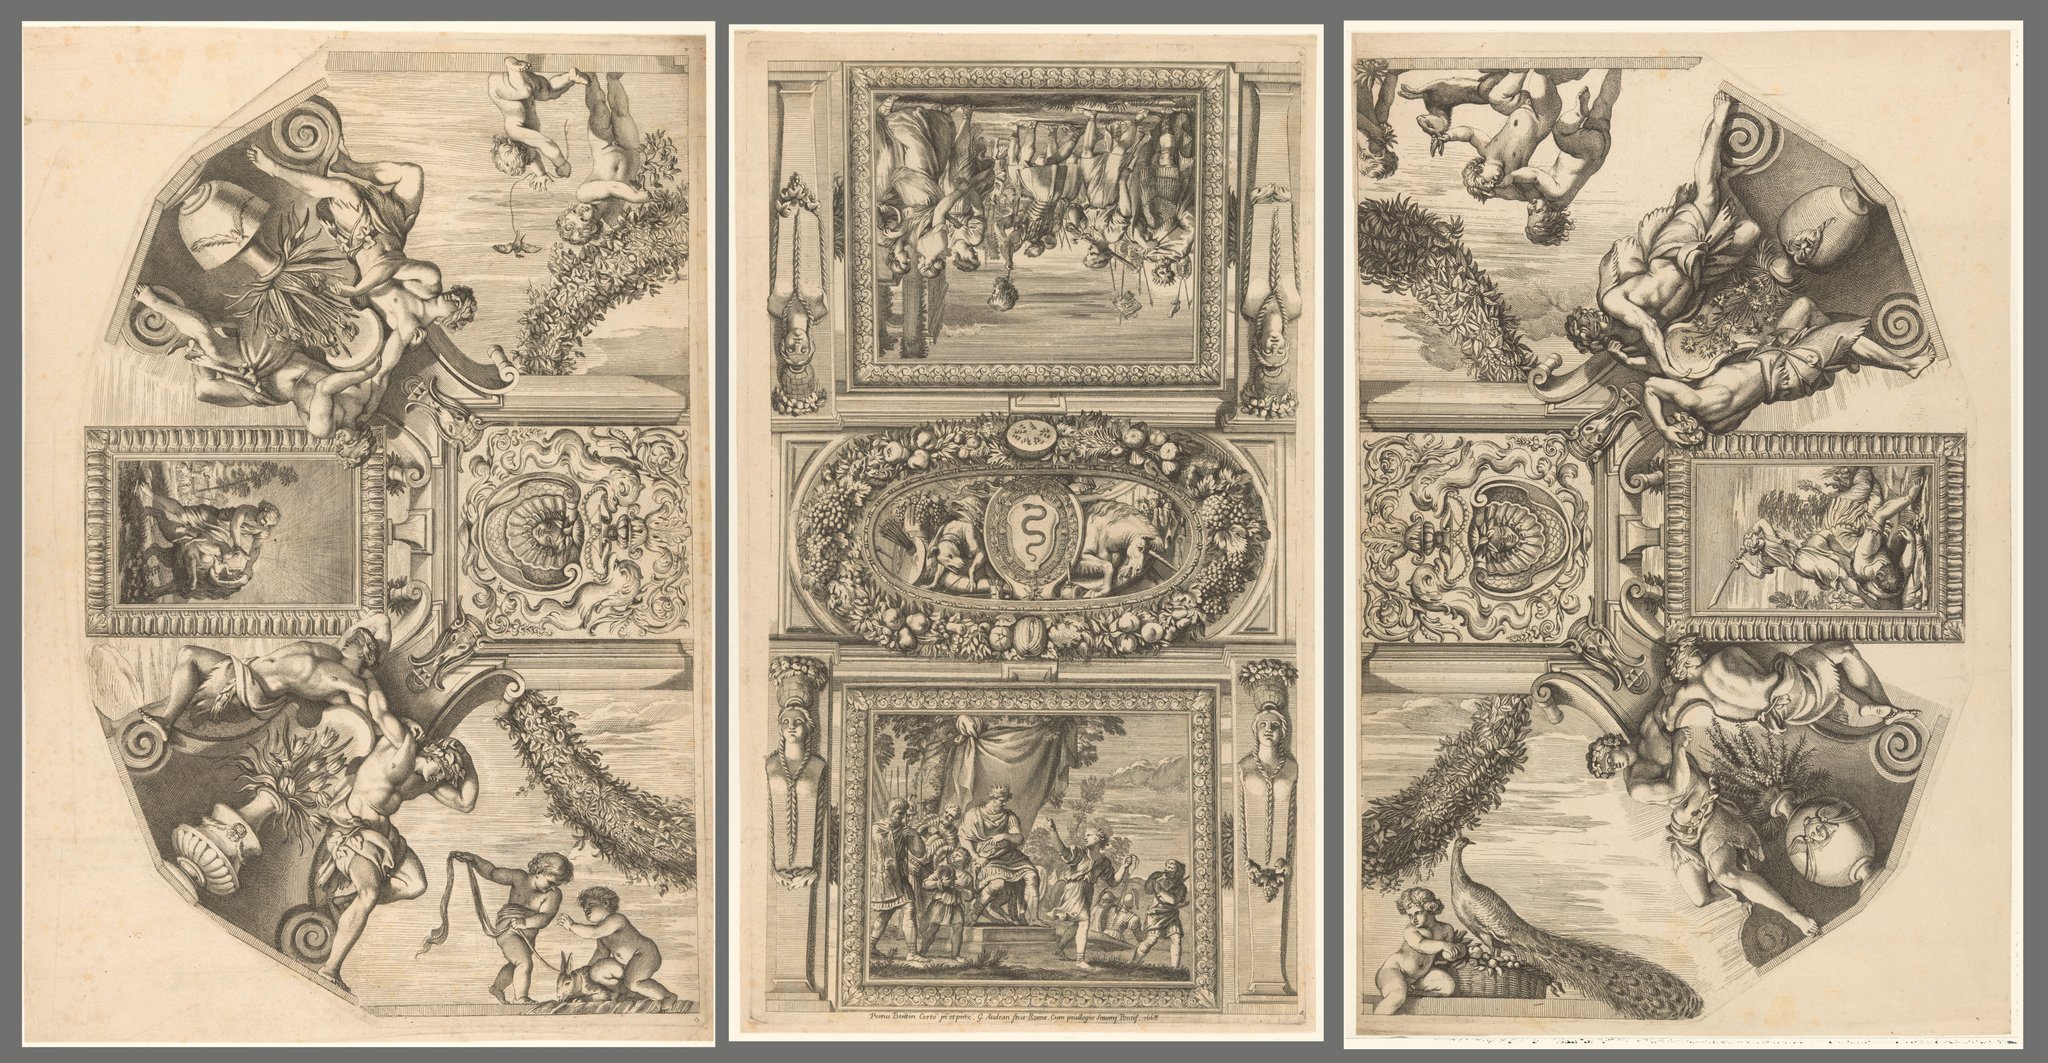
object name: print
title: Verlorengegane plafondschildering in de Villa del Pigneto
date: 1668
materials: paper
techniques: engraving, etching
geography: vatican city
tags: ornaments ~ art, story of david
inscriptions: collector's mark: ‘Hinloopen’, collector's mark: Lugt 11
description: Naar een verlorengegane plafondschildering door Pietro da Cortona in Villa del Pigneto te Rome. Deze prent maakte oorspronkelijk deel uit van liber nr. 22 van de Atlas van Rome, uit de collectie Hinloopen. In dit album waren een aantal prentreeksen naar bekende zeventiende eeuwse frescoseries bijeengebonden. In 1709 heeft Schijnvoet op last van de burgemeesters van Amsterdam de collectie herordend. De prenten uit liber 22 kwamen terrecht in Schijnvoet boek nr. 10. De laatst gedateerde reeks in het album is gedateerd 1691. Het album moet dus na deze datum gebonden zijn. De band is in de Rijksakademietijd uit elkaar gehaald. De marges van de prenten zijn bij het opbergen in het Rijksprentenkabinet vaak drastisch afgesneden. Van een aantal series waren de prenten teruggeslagen om in het album te passen. (Zie: Waals, Jan van der. De prentschat van Michiel Hinloopen. 's-Gravenhage: SDU uitgeverij, 1988, pp. 173-174.)